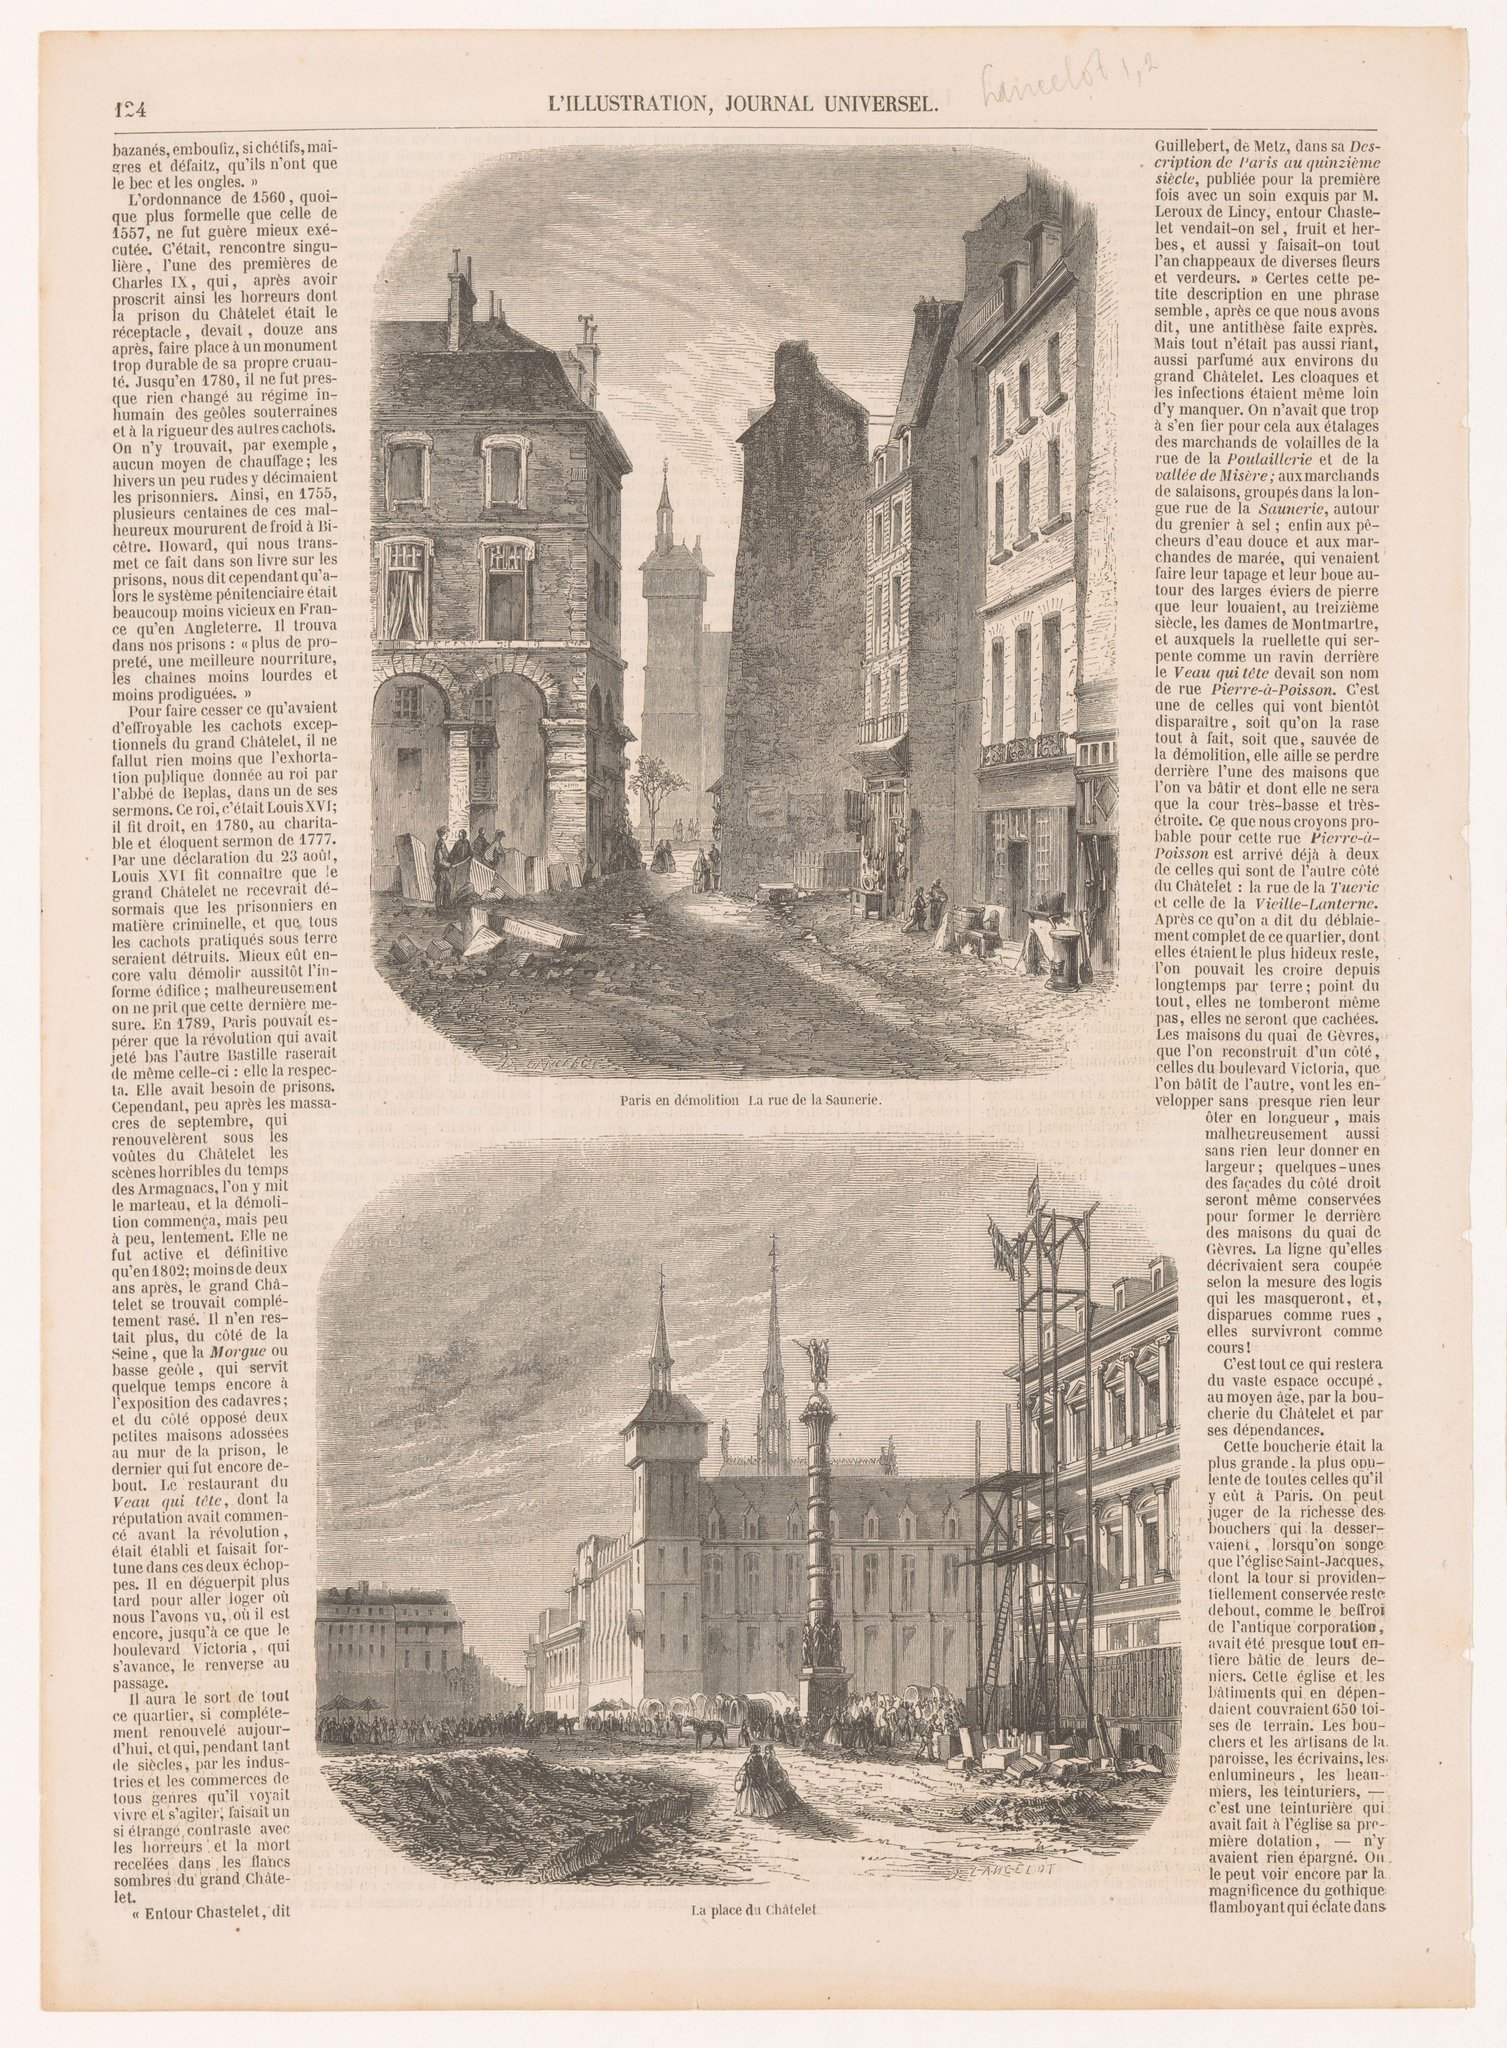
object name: page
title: Paris en démolition. La rue de la Saunerie; La place du Châtelet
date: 1856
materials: paper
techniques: letterpress printing, engraving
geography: paris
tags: demolition of building, building-site, paris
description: Prent uit: L'Illustration, vol. 28, nr. 704, 23 augustus 1856, p. 124.